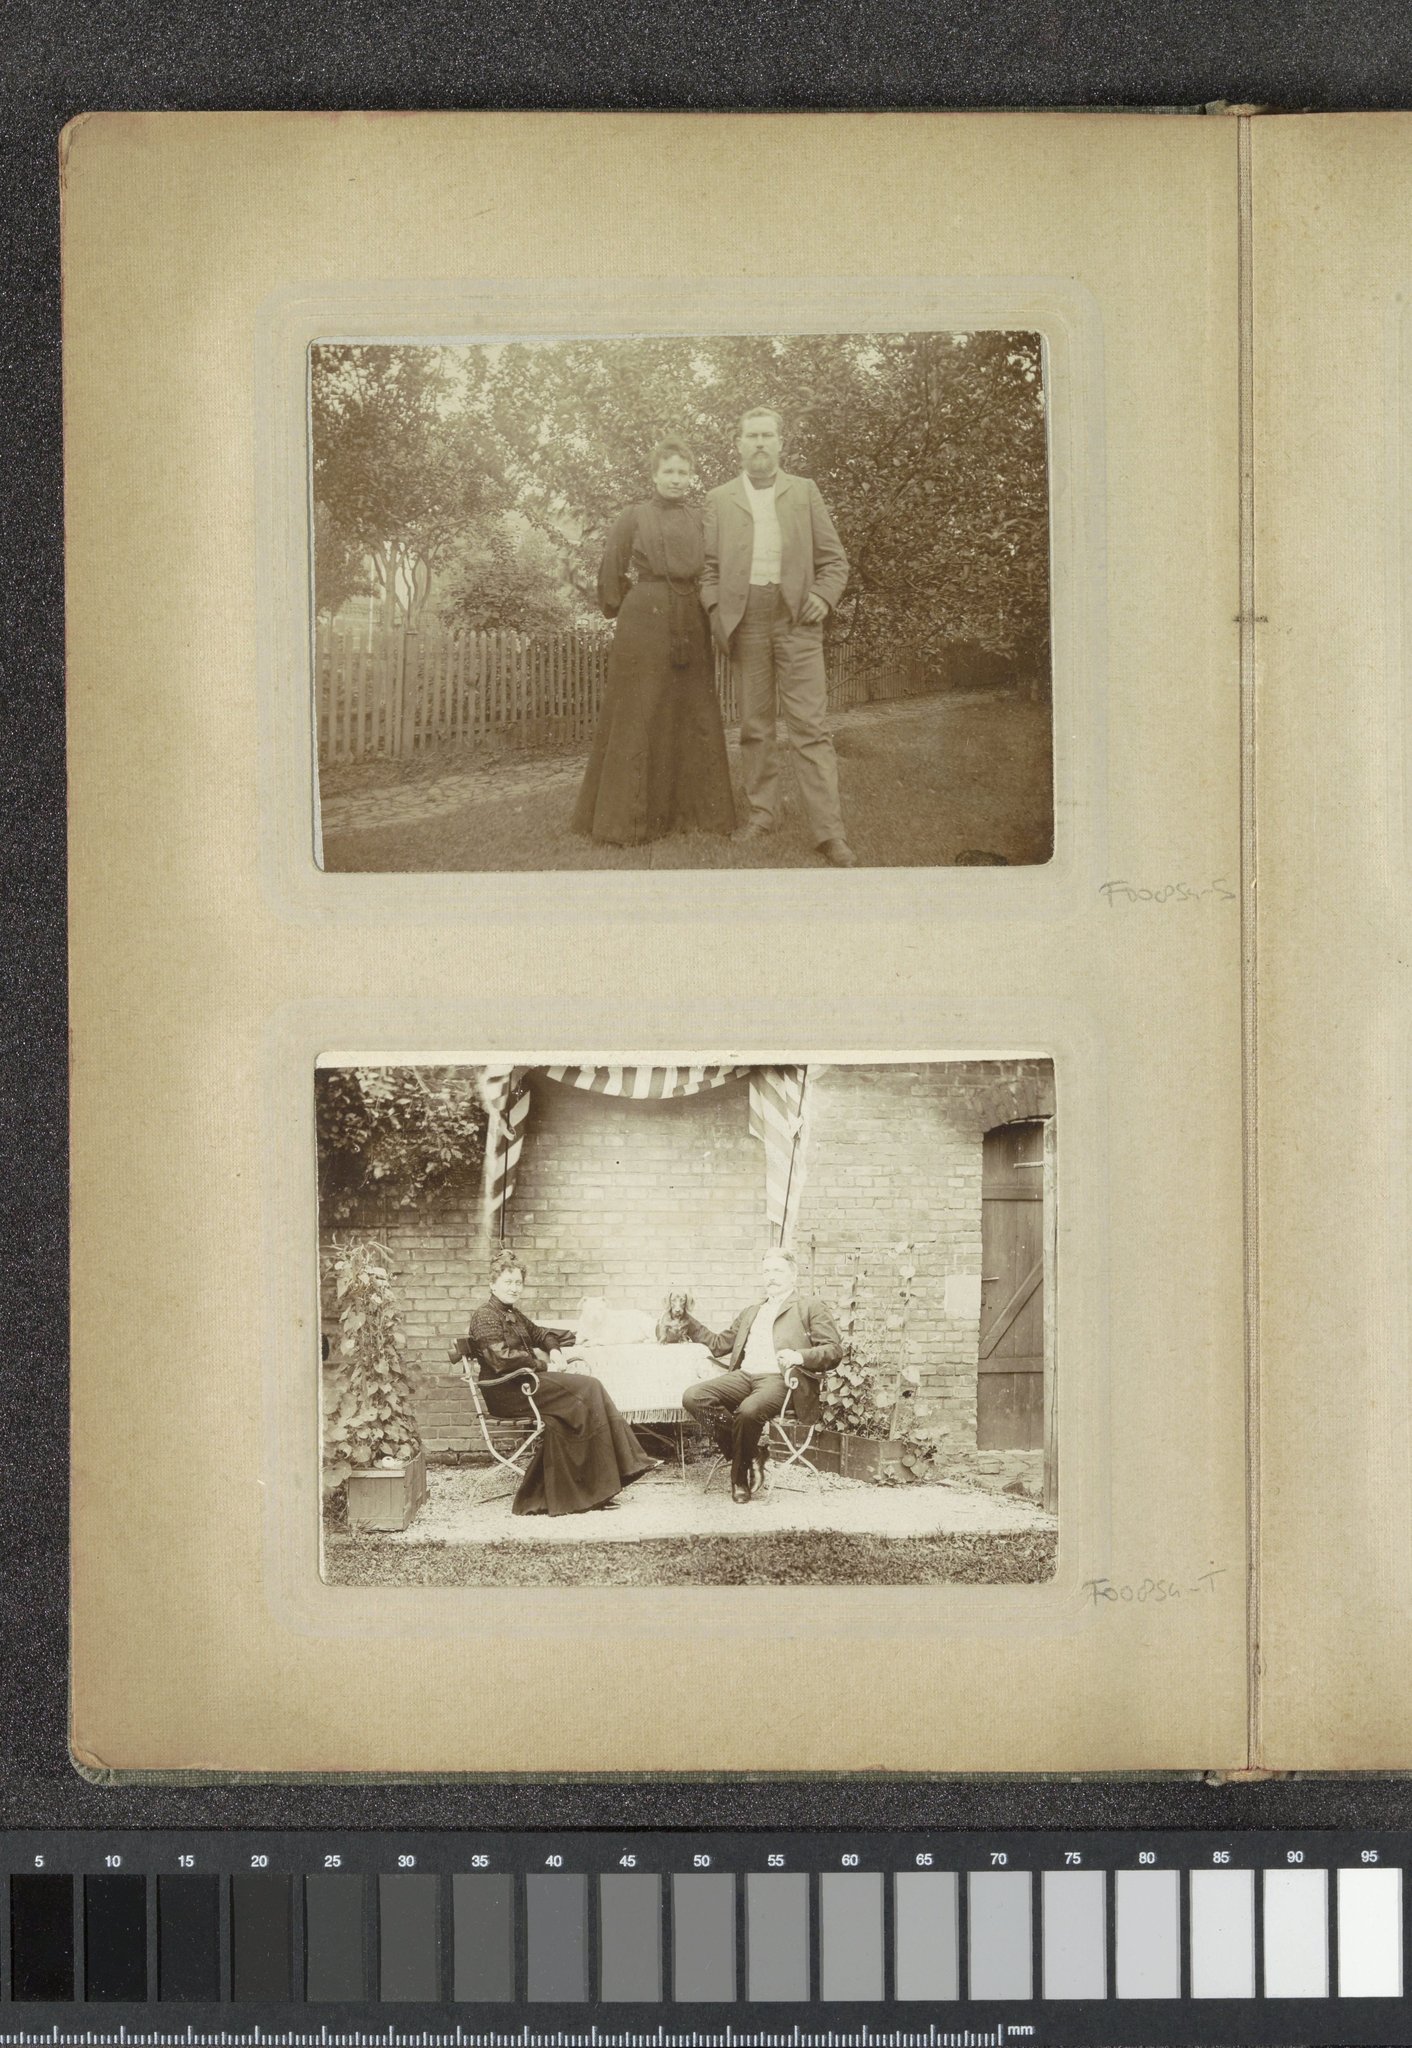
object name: photograph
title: Portret van een man, een vrouw en twee honden zittend bij een tafel in een tuin in Duitsland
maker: Anonymous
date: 1890-1910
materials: cardboard, paper, photographic support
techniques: daylight paper print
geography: germany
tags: adult woman, garden, adult man, dog, germany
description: Onderdeel van Fotoalbum van Carl Heinrich Fliegenschmidt, gevangenisdirecteur te Oslebshausen.